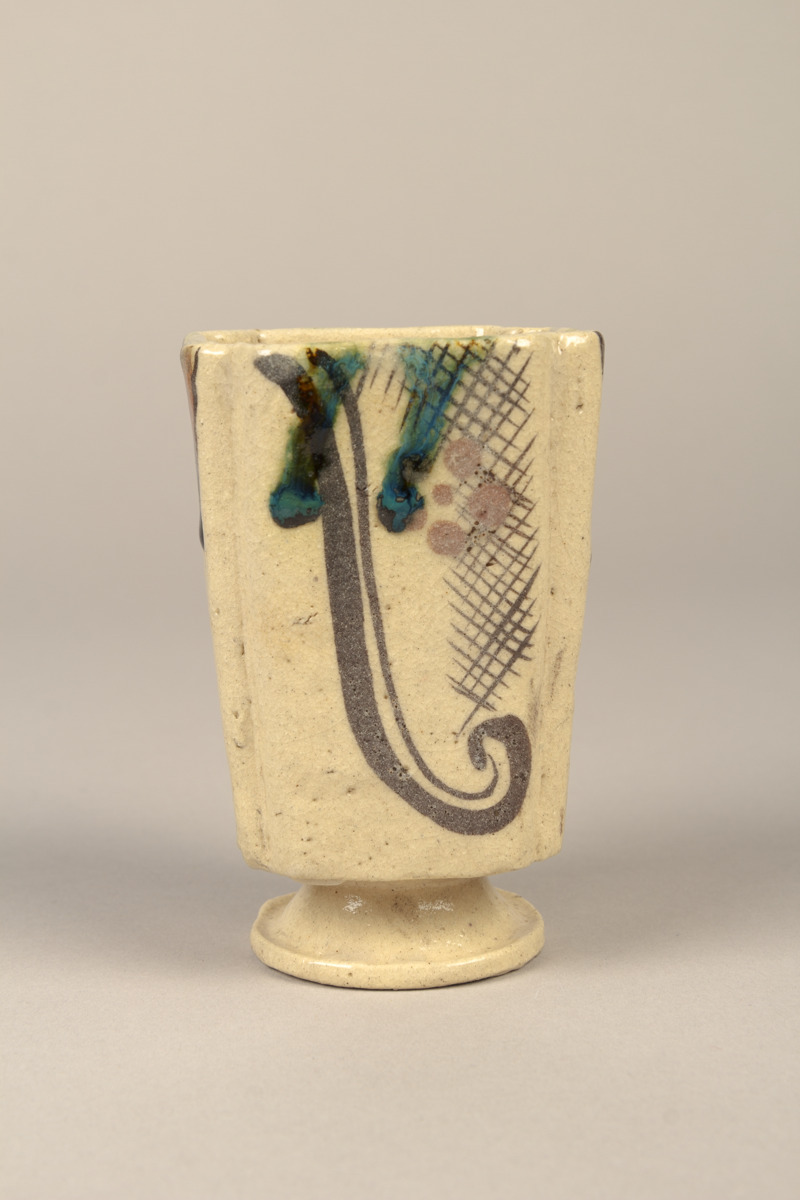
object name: food vessel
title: One from set of five squared food vessels (mukōzuke) for tea-gathering meal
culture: japanese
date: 1601-1633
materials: copper, iron, stoneware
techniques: overglaze